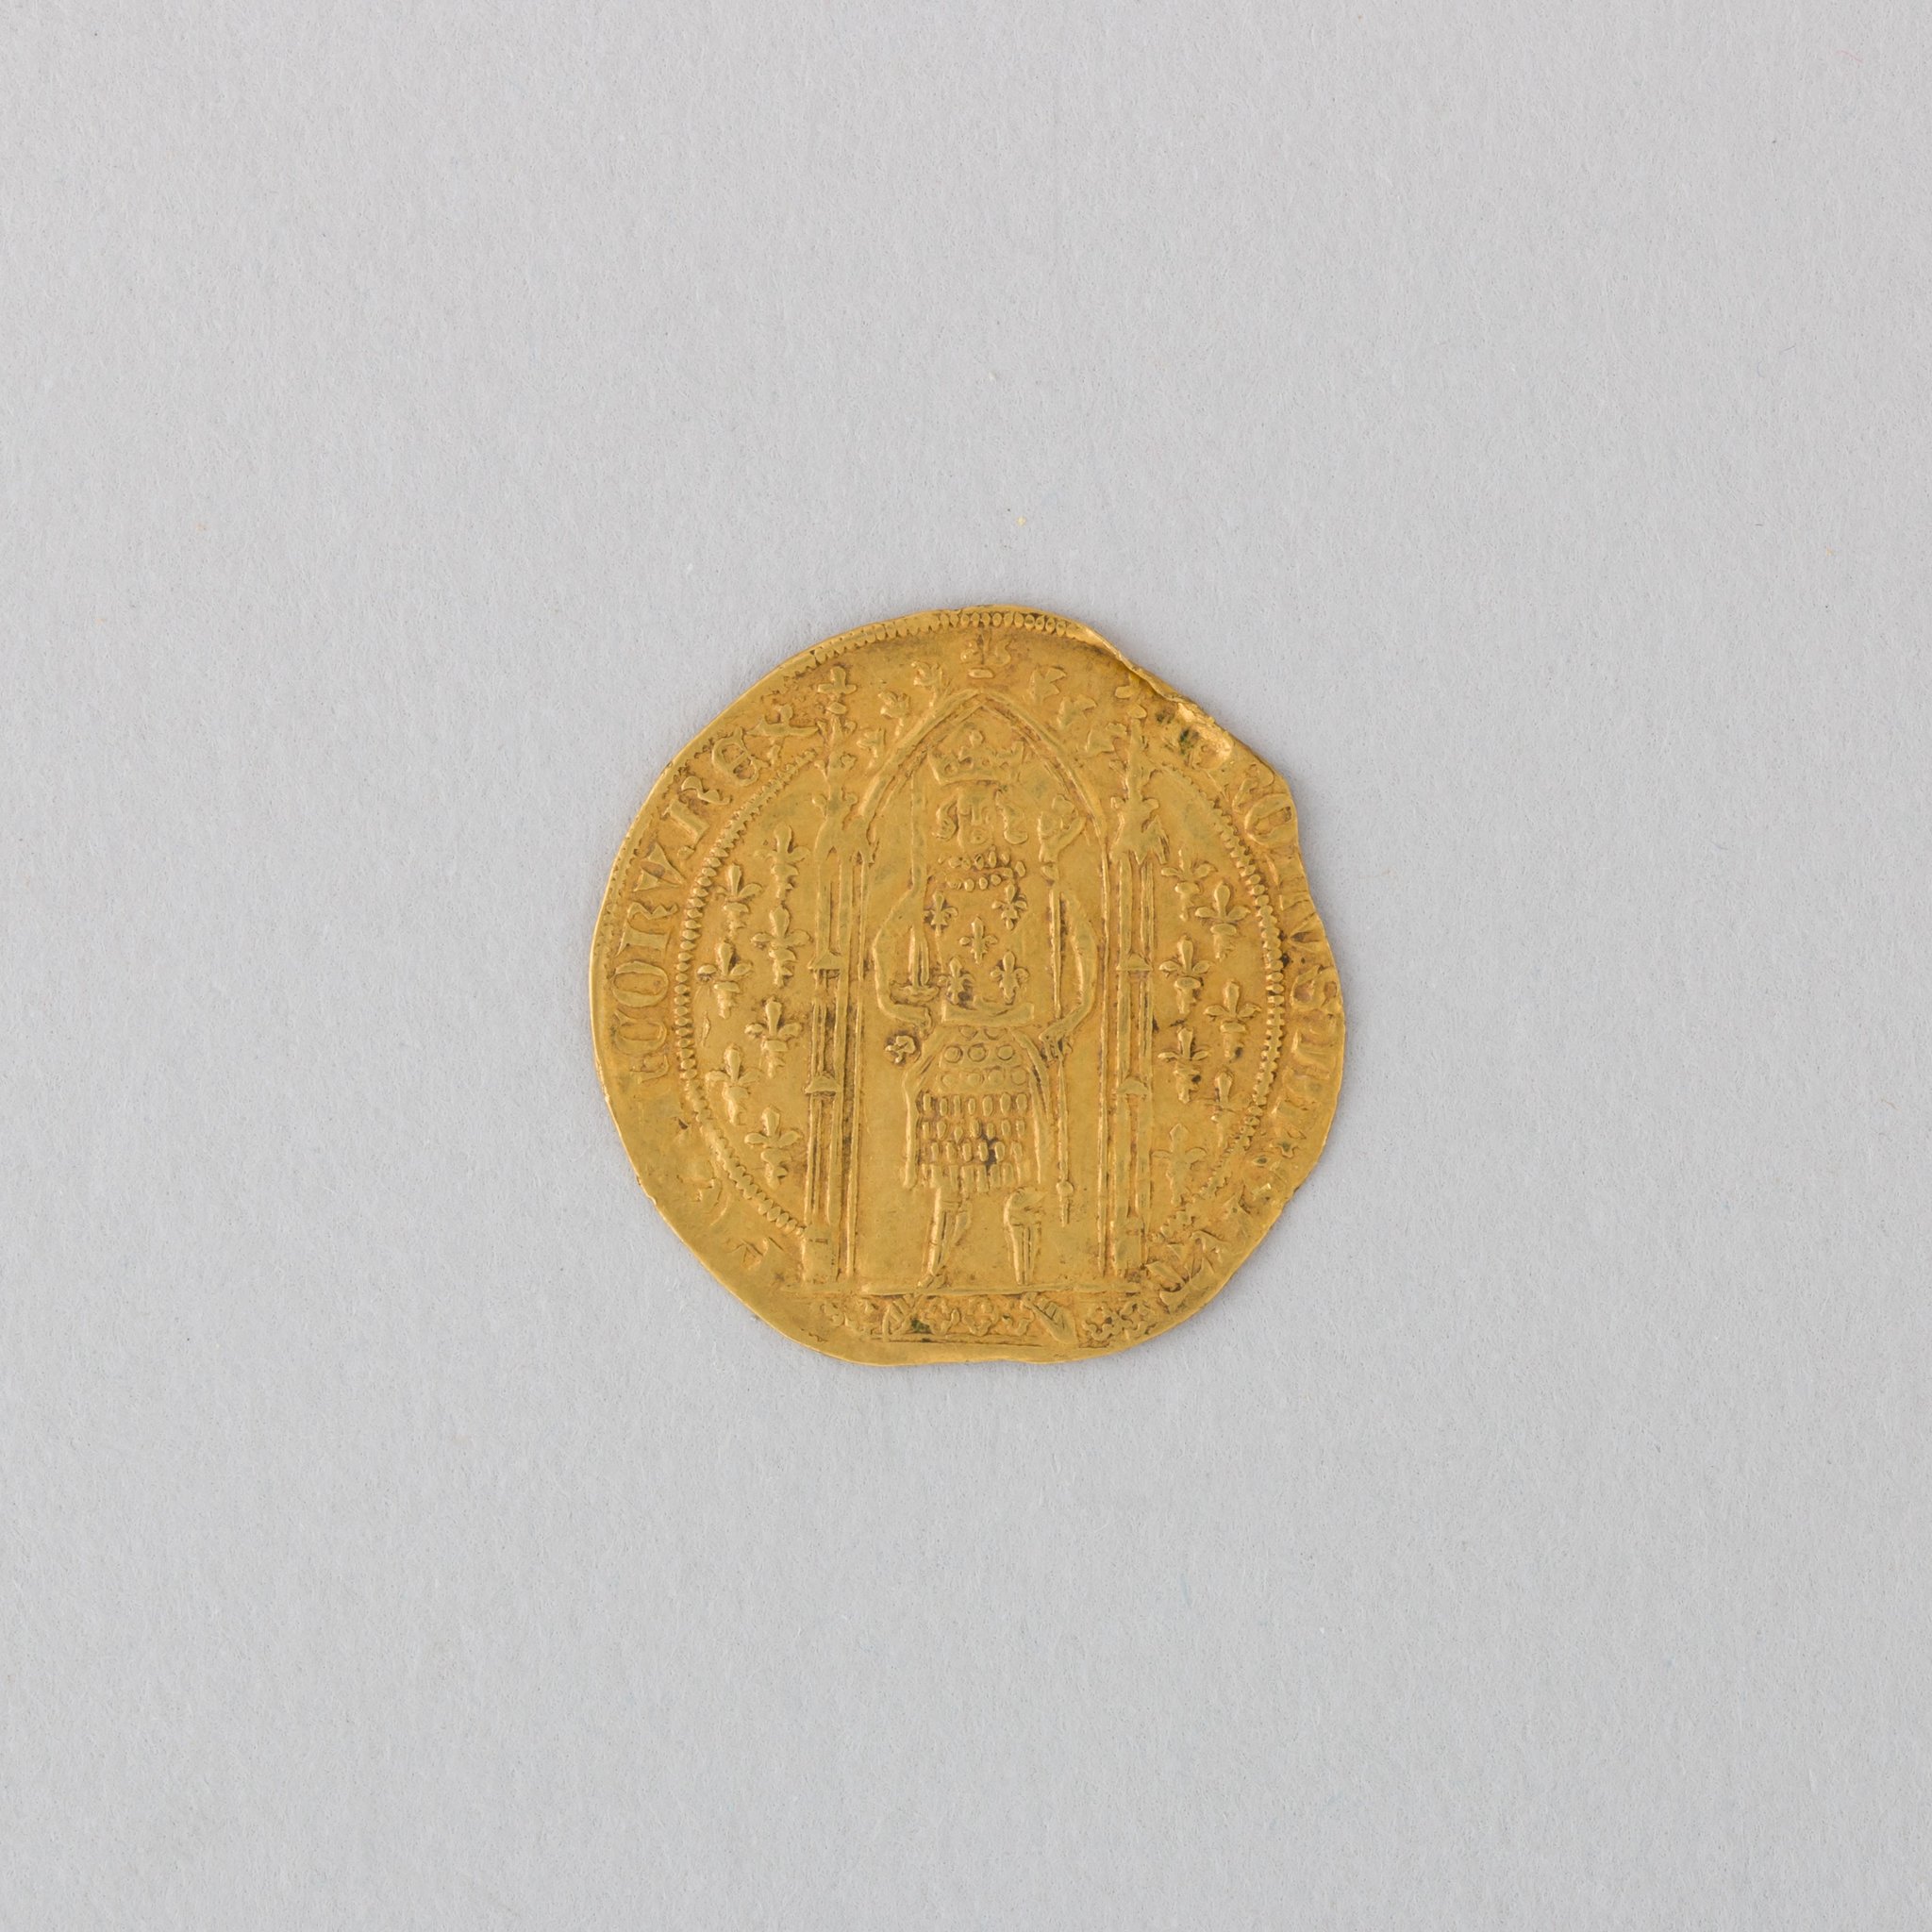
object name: coin franc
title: Coin (Franc) Showing Charles V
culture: french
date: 1364-1380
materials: gold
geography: france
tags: men,coins